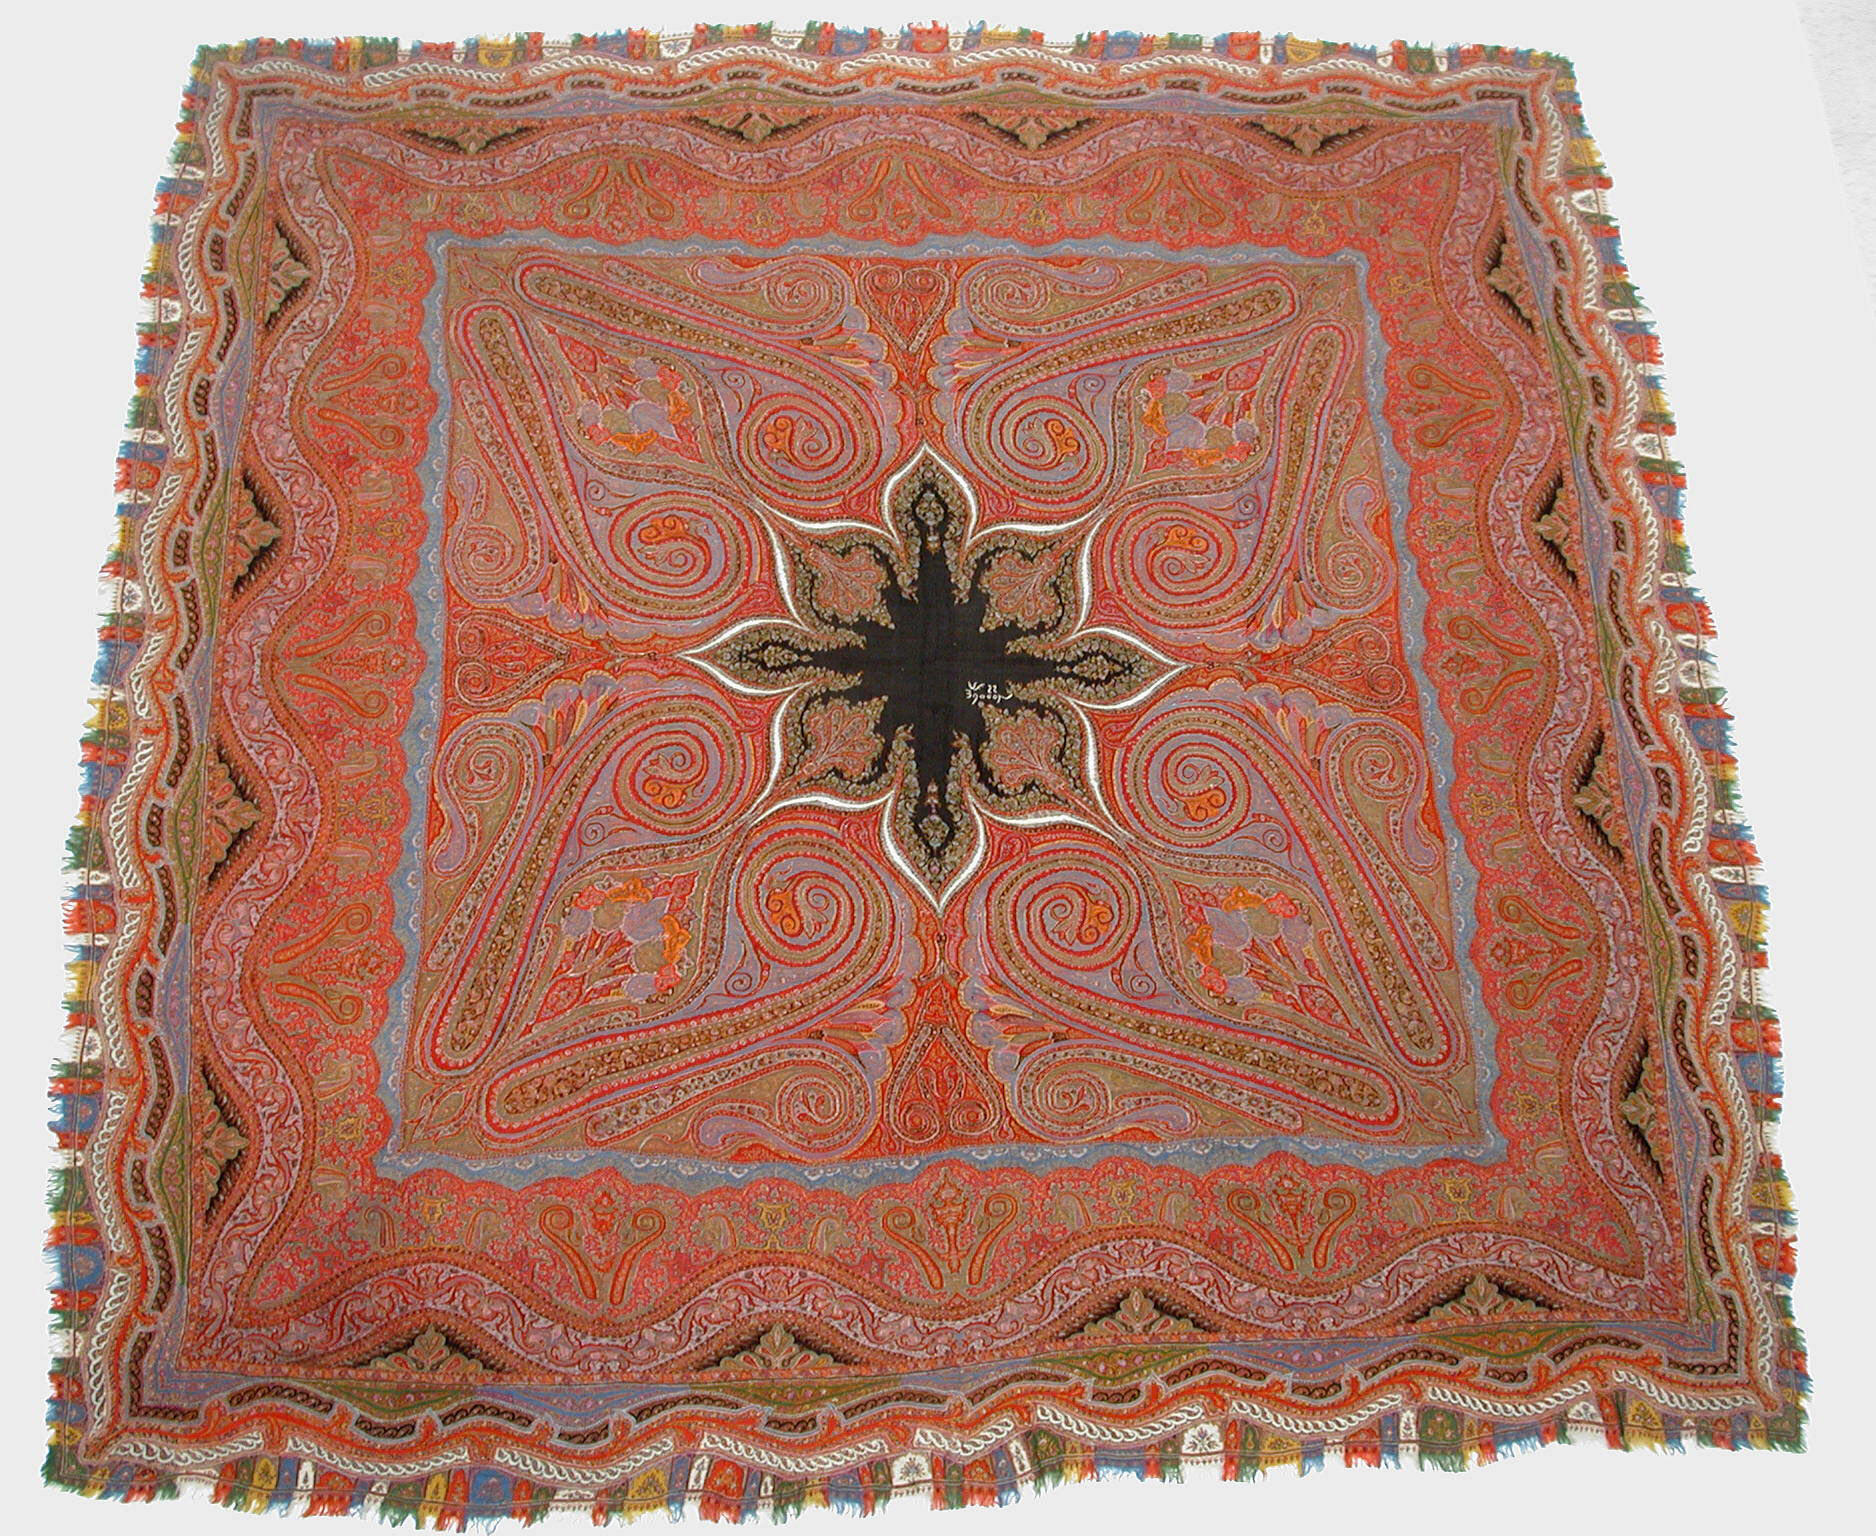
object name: shawl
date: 1834-1866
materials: silk, wool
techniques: embroidery, interlocking, weave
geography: india